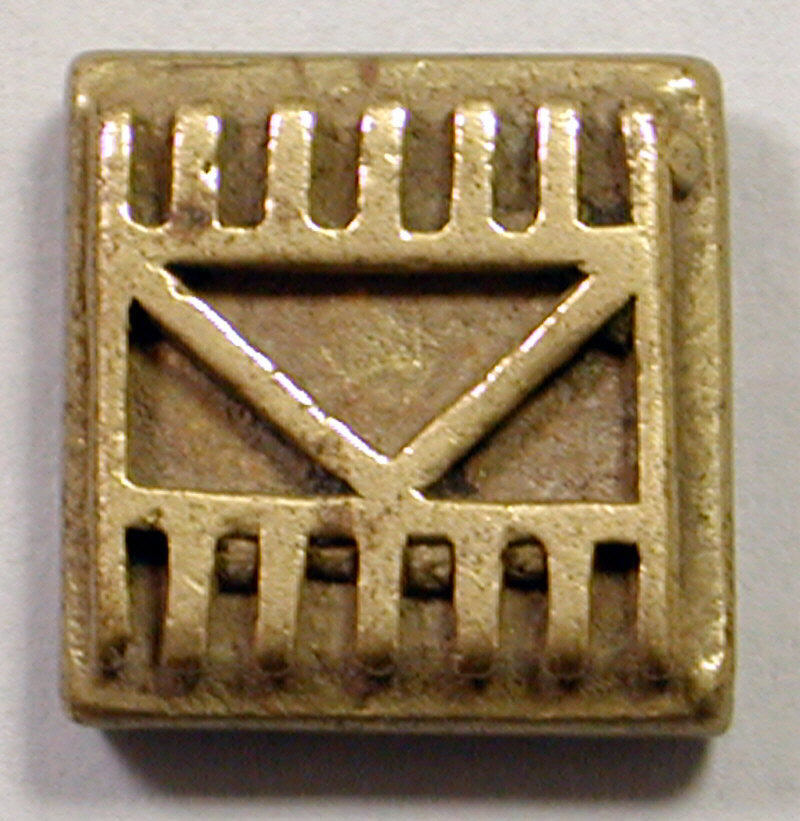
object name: weight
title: Gold Weight: Geometric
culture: akan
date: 1701-1900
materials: brass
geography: ghana